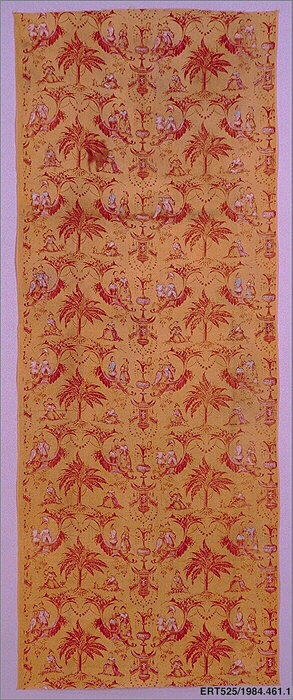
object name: length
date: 1850-1859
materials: cotton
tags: human figures,trees